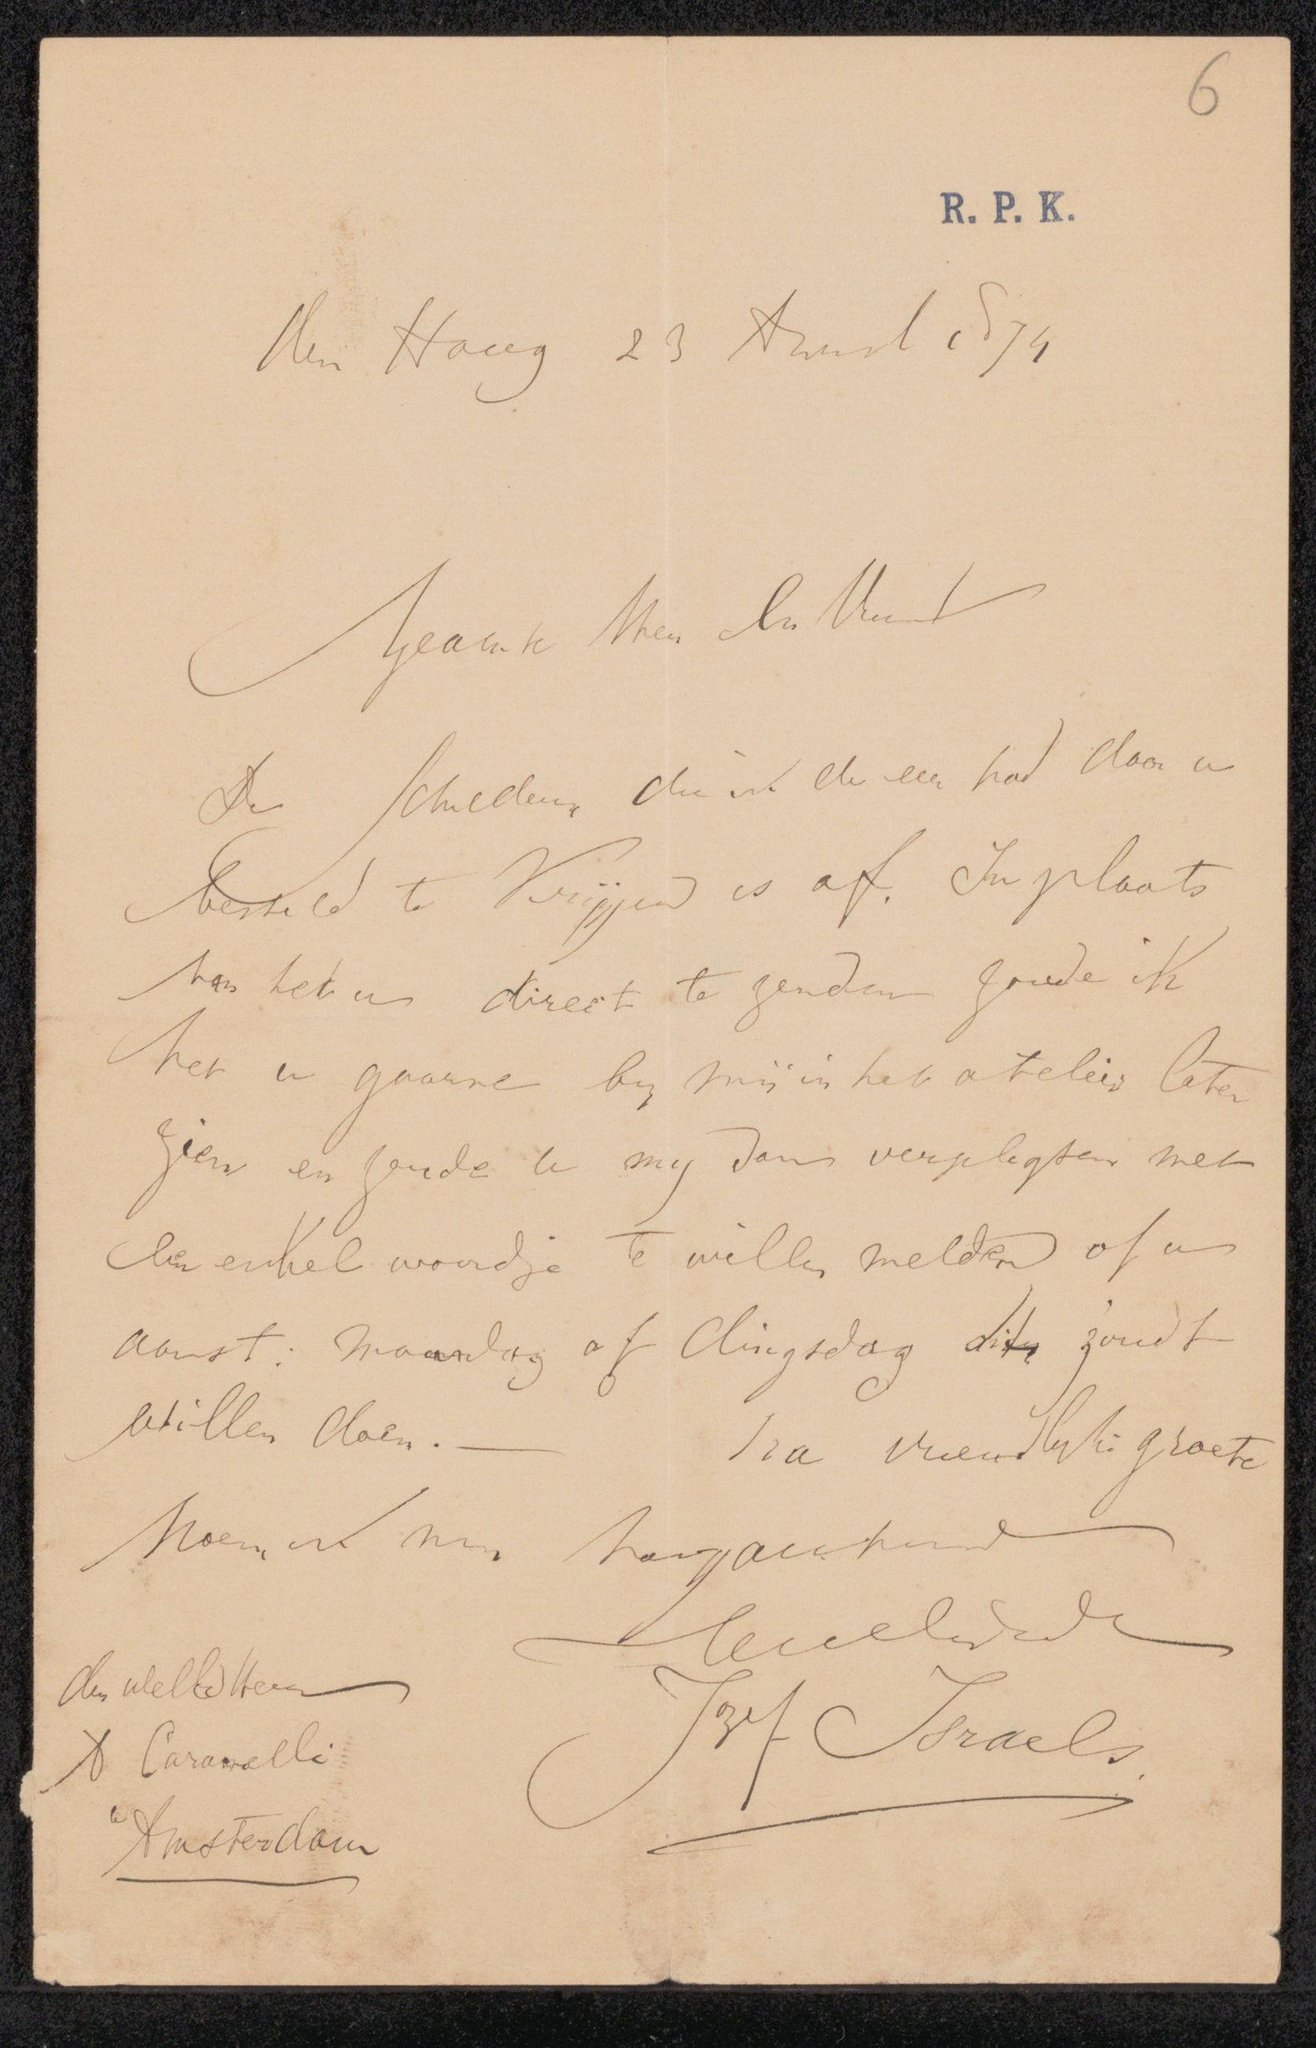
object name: letter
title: Brief aan Alberto Caramelli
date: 1874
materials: ink, paper, pencil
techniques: pen, writing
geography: the hague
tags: utrecht, amsterdam, publisher, alberto caramelli, the graphic arts, workshop, studio of the artist (in general)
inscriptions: collector's mark: Lugt 2233